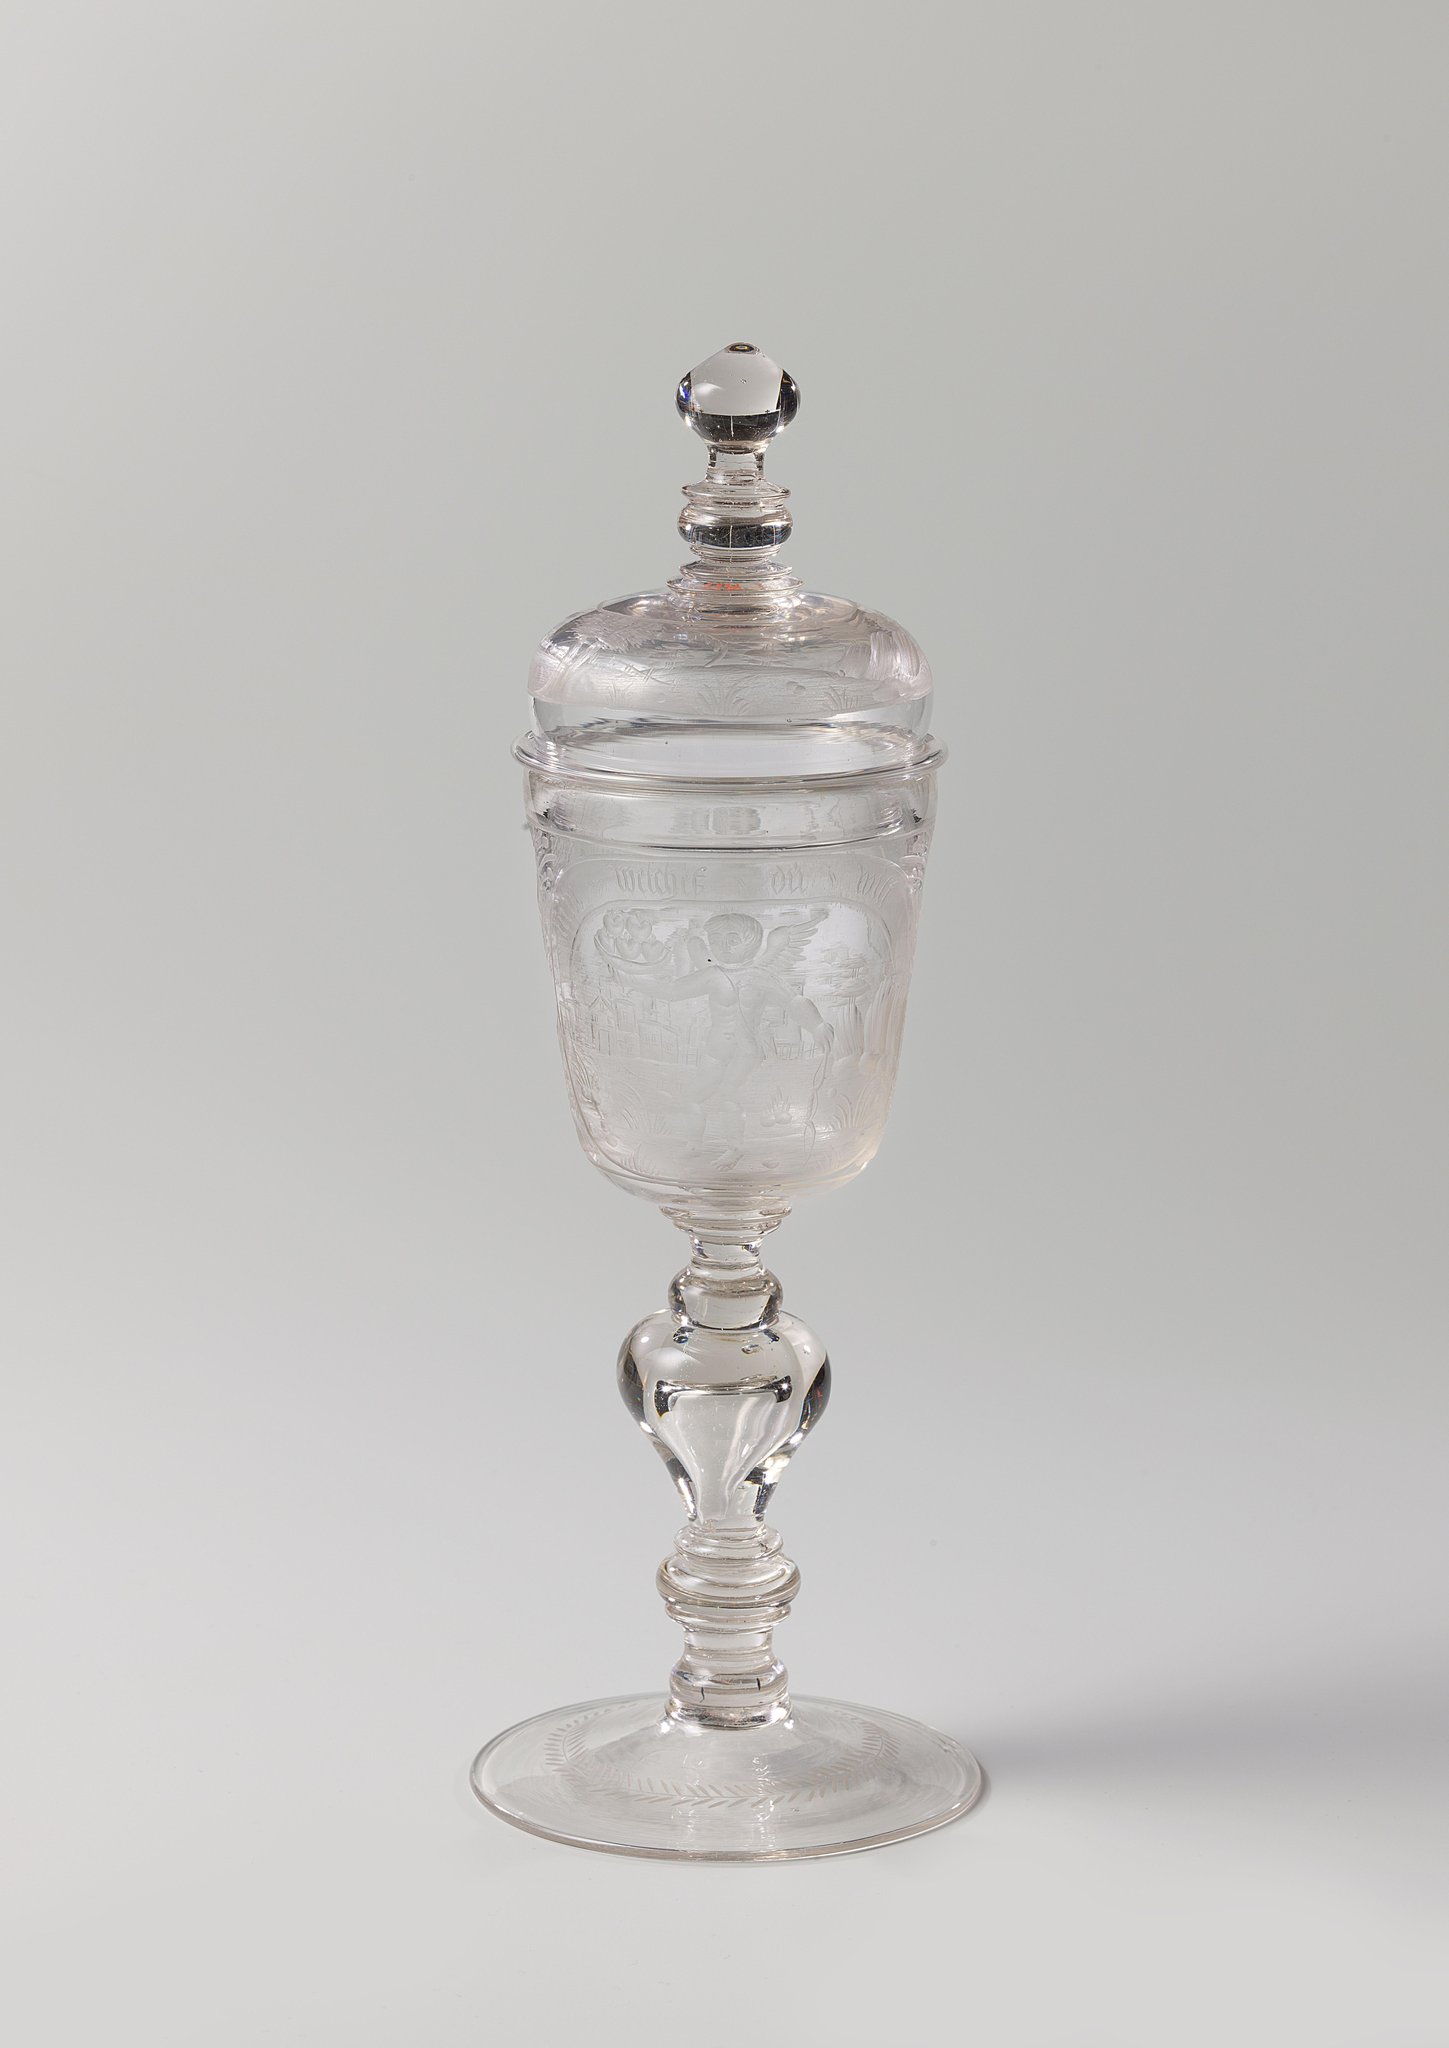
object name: goblet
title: Bokaal, met voorstellingen van putti met brandende harten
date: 1700-1725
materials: glass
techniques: glassblowing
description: Bokaal, van helder, kleurloos glas, met gegraveerde voorstellingen van putti. Aan de voorzijde een voorstelling van een putto boven een altaar waarop twee brandende harten liggen. Hierboven het opschrift: ICH HAB GE NUNG AN EINEN. Op de achterzijde een putto in een landschap met vijf brandende harten in zijn rechterhand. Hierboven het opschrift: NIMT WELCHES DU WILST.